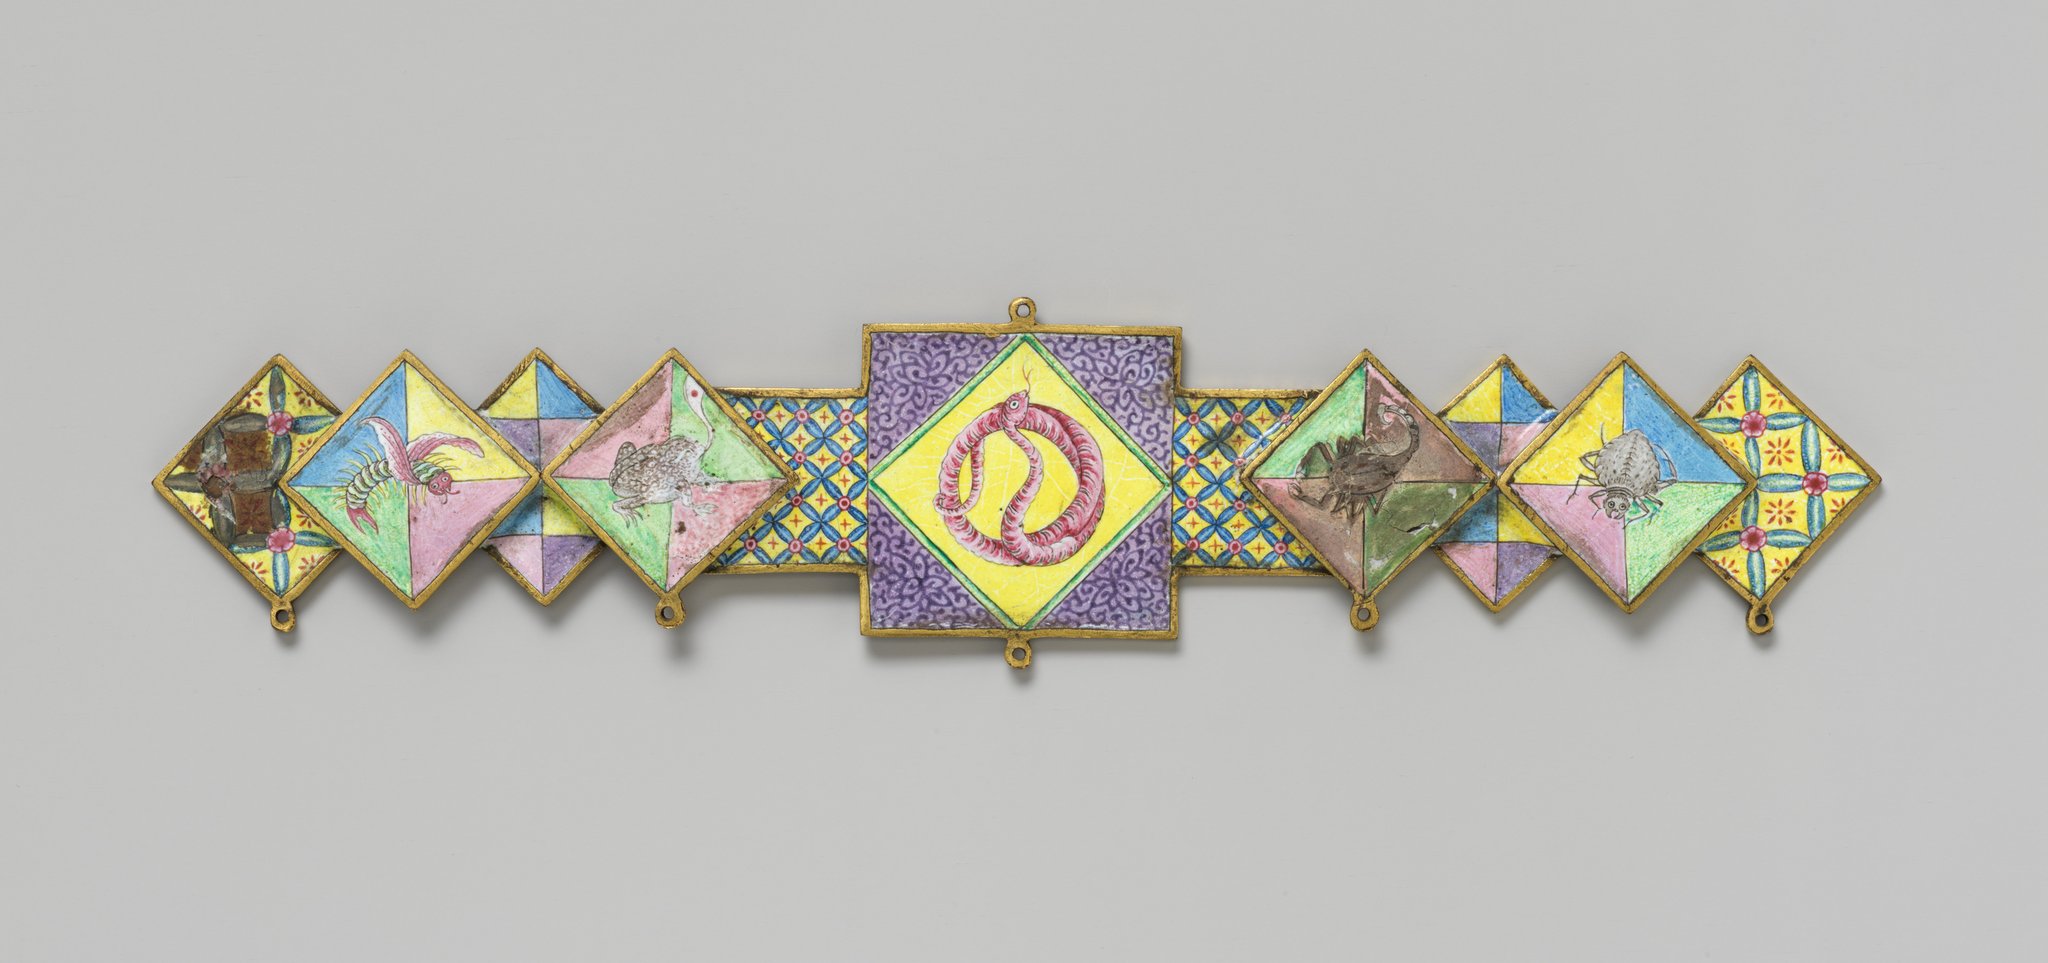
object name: plaque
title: Plaque with the five poisonous creatures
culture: chinese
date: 1801-1900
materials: enamel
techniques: painting